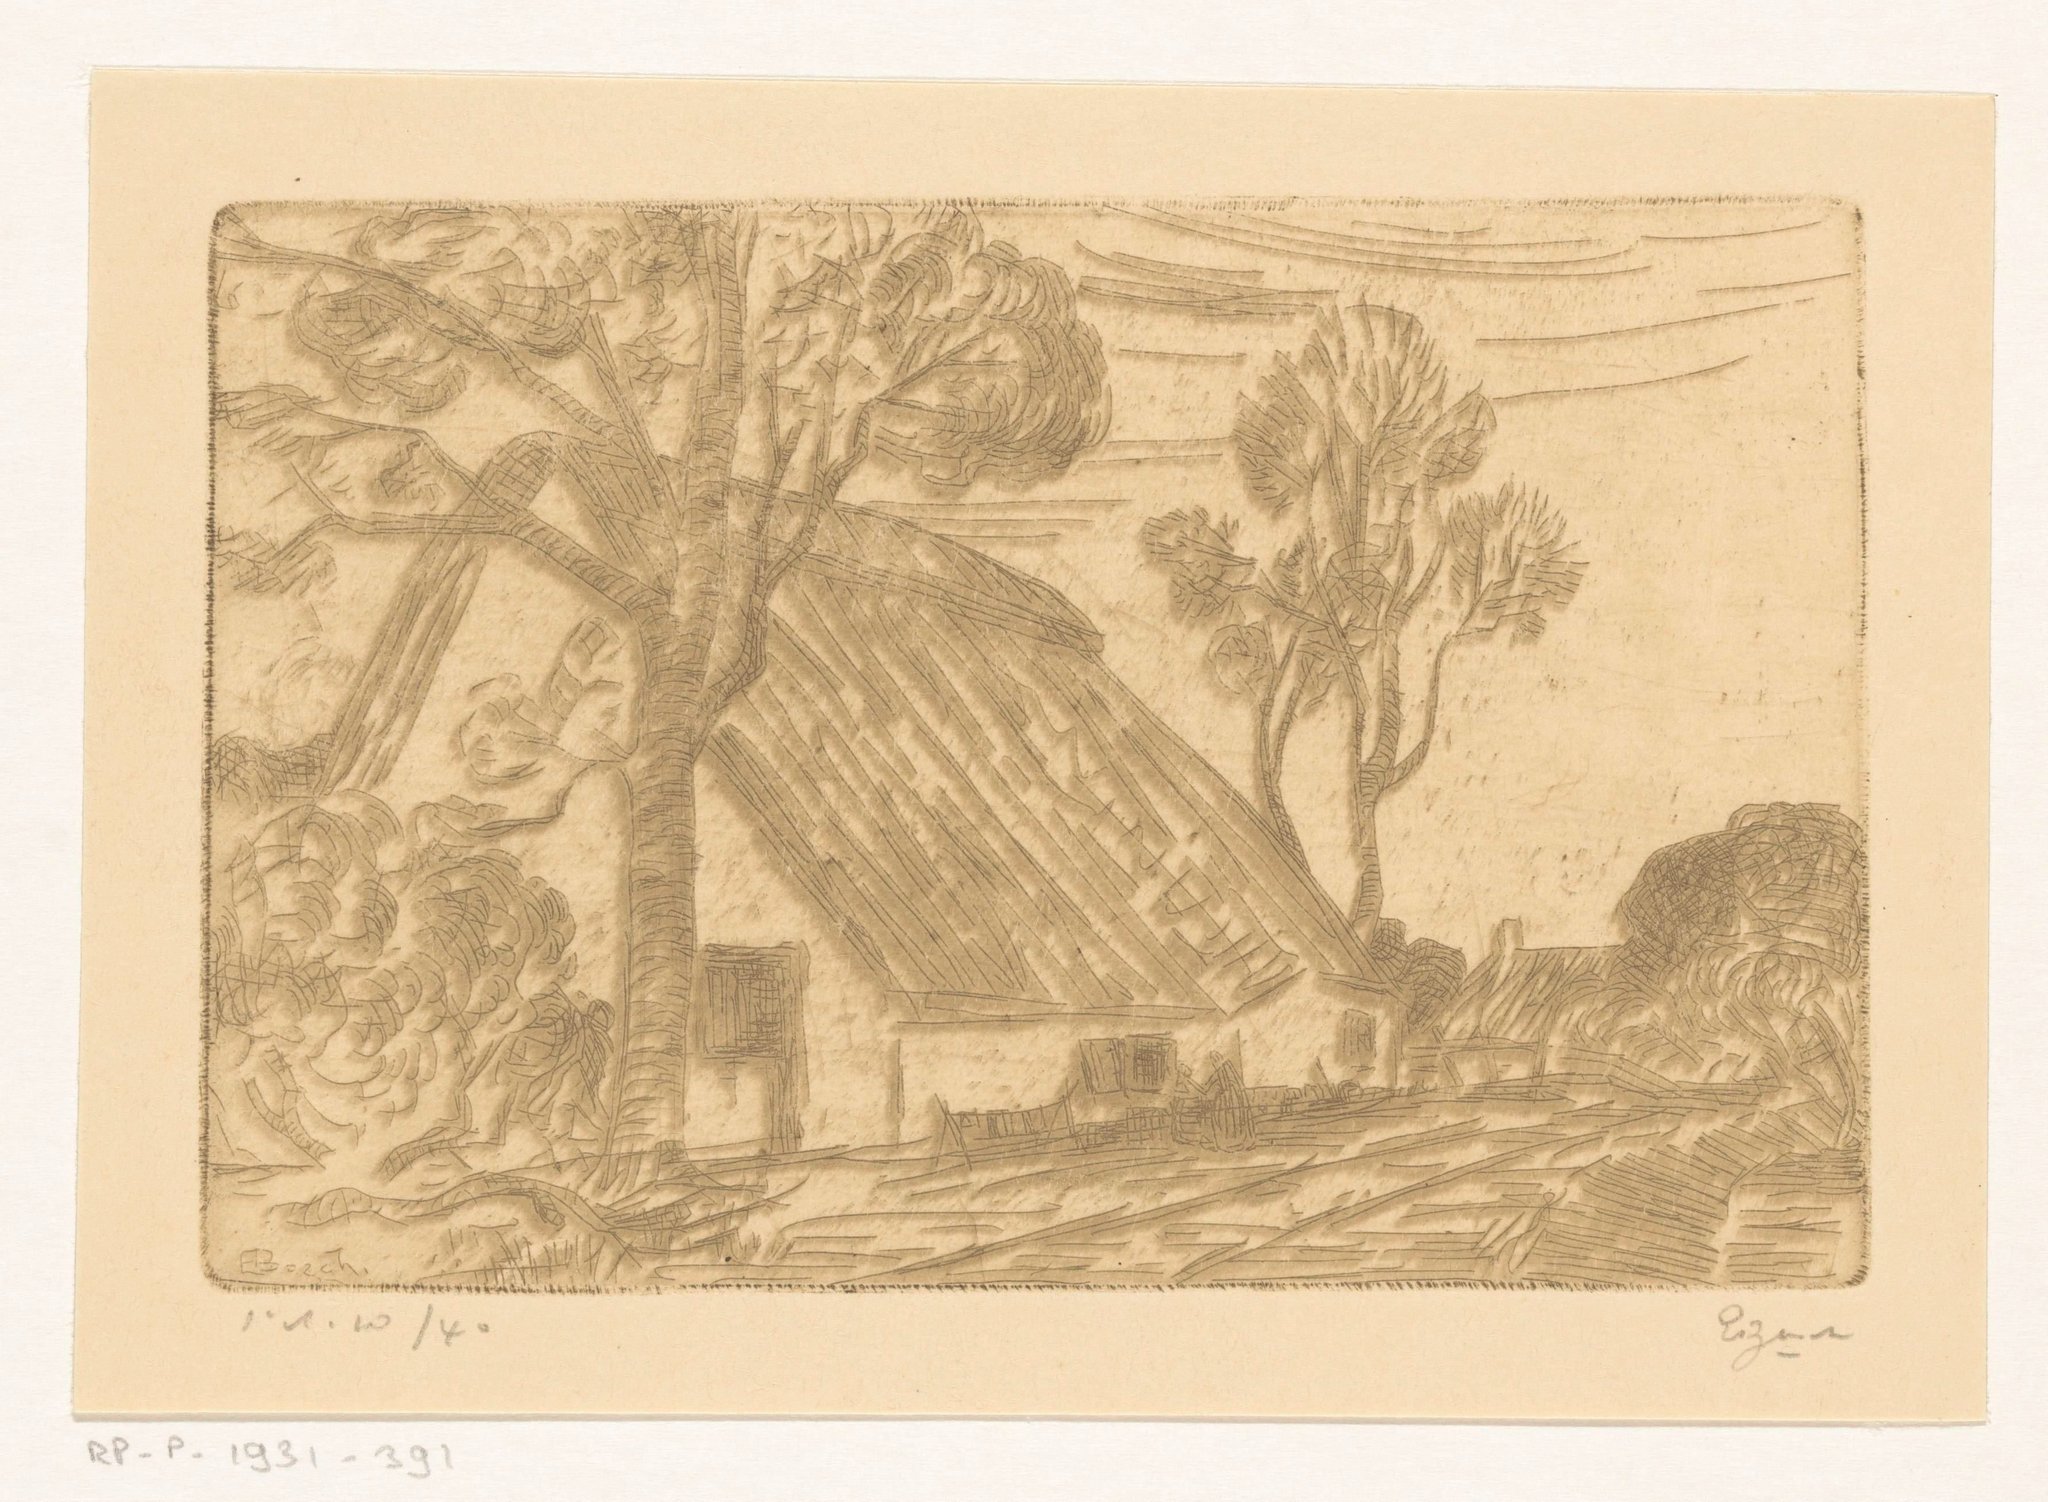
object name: print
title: Hollands landschap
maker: etienne bosch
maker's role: print maker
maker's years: 1863-1933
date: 1873-1931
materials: paper, ink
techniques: drypoint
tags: farm or solitary house in landscape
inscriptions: collector's mark: Lugt 2228, signature: ‘EBosch’, signature: ‘EBosch’, edition: ‘1e et. 10/40’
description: Gezicht op een boerenwoning tussen enkele bomen.